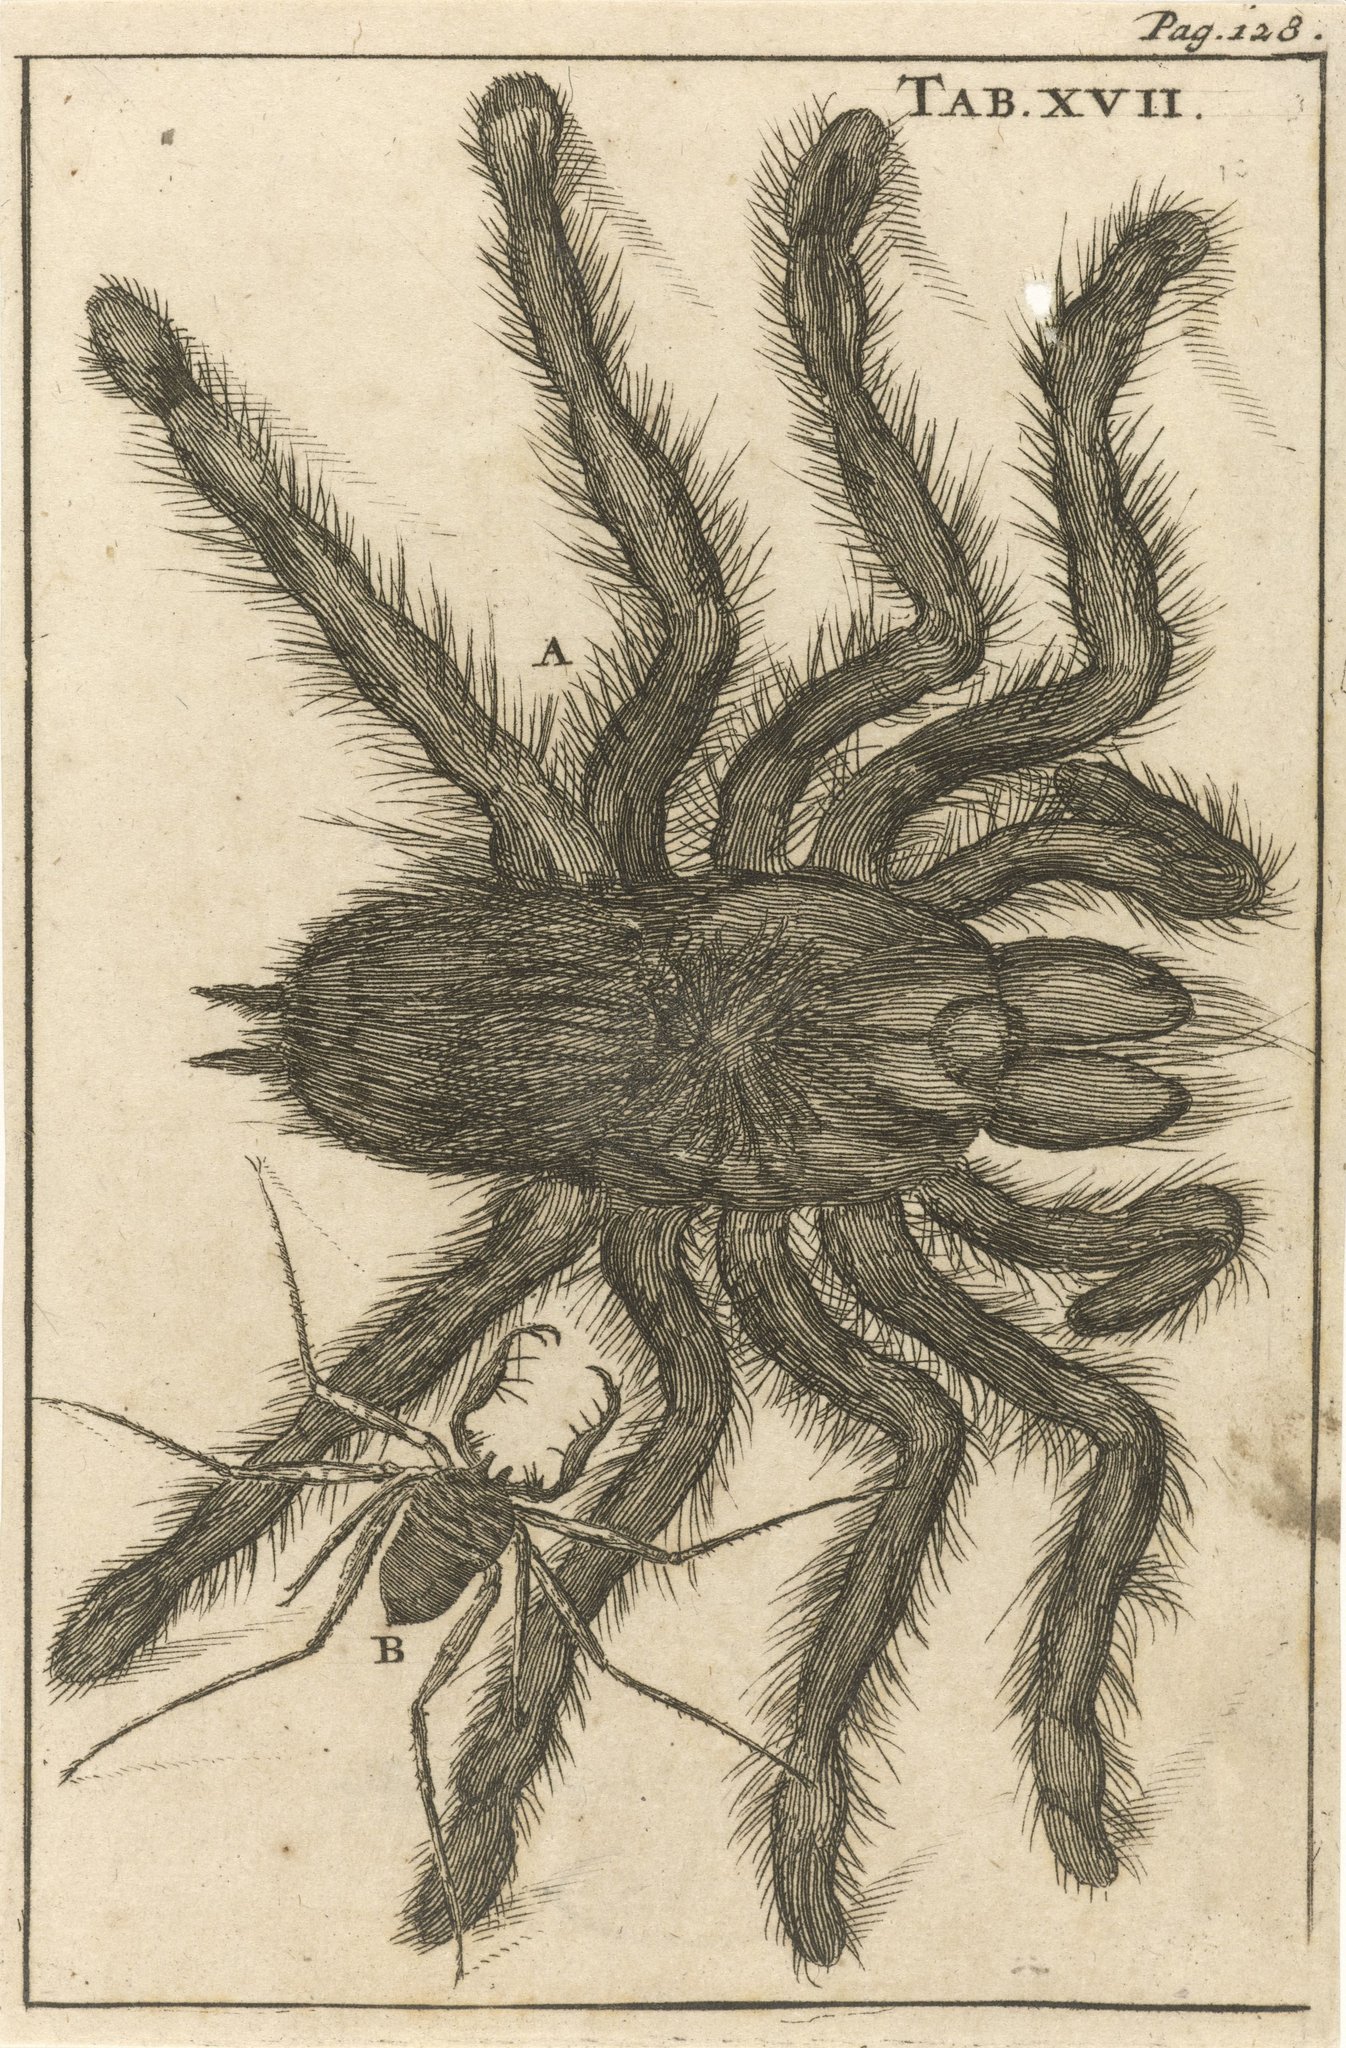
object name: print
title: Spinnen XVII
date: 1680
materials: paper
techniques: etching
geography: amsterdam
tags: insects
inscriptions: collector's mark: Lugt 2228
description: Illustratie opgenomen in: Blankaart, Steven. Schou-burg der rupsen, wormen, ma'den, en vliegende dierkens daar uit voortkomende. Amsterdam: Jan Claesz ten Hoorn, 1680.